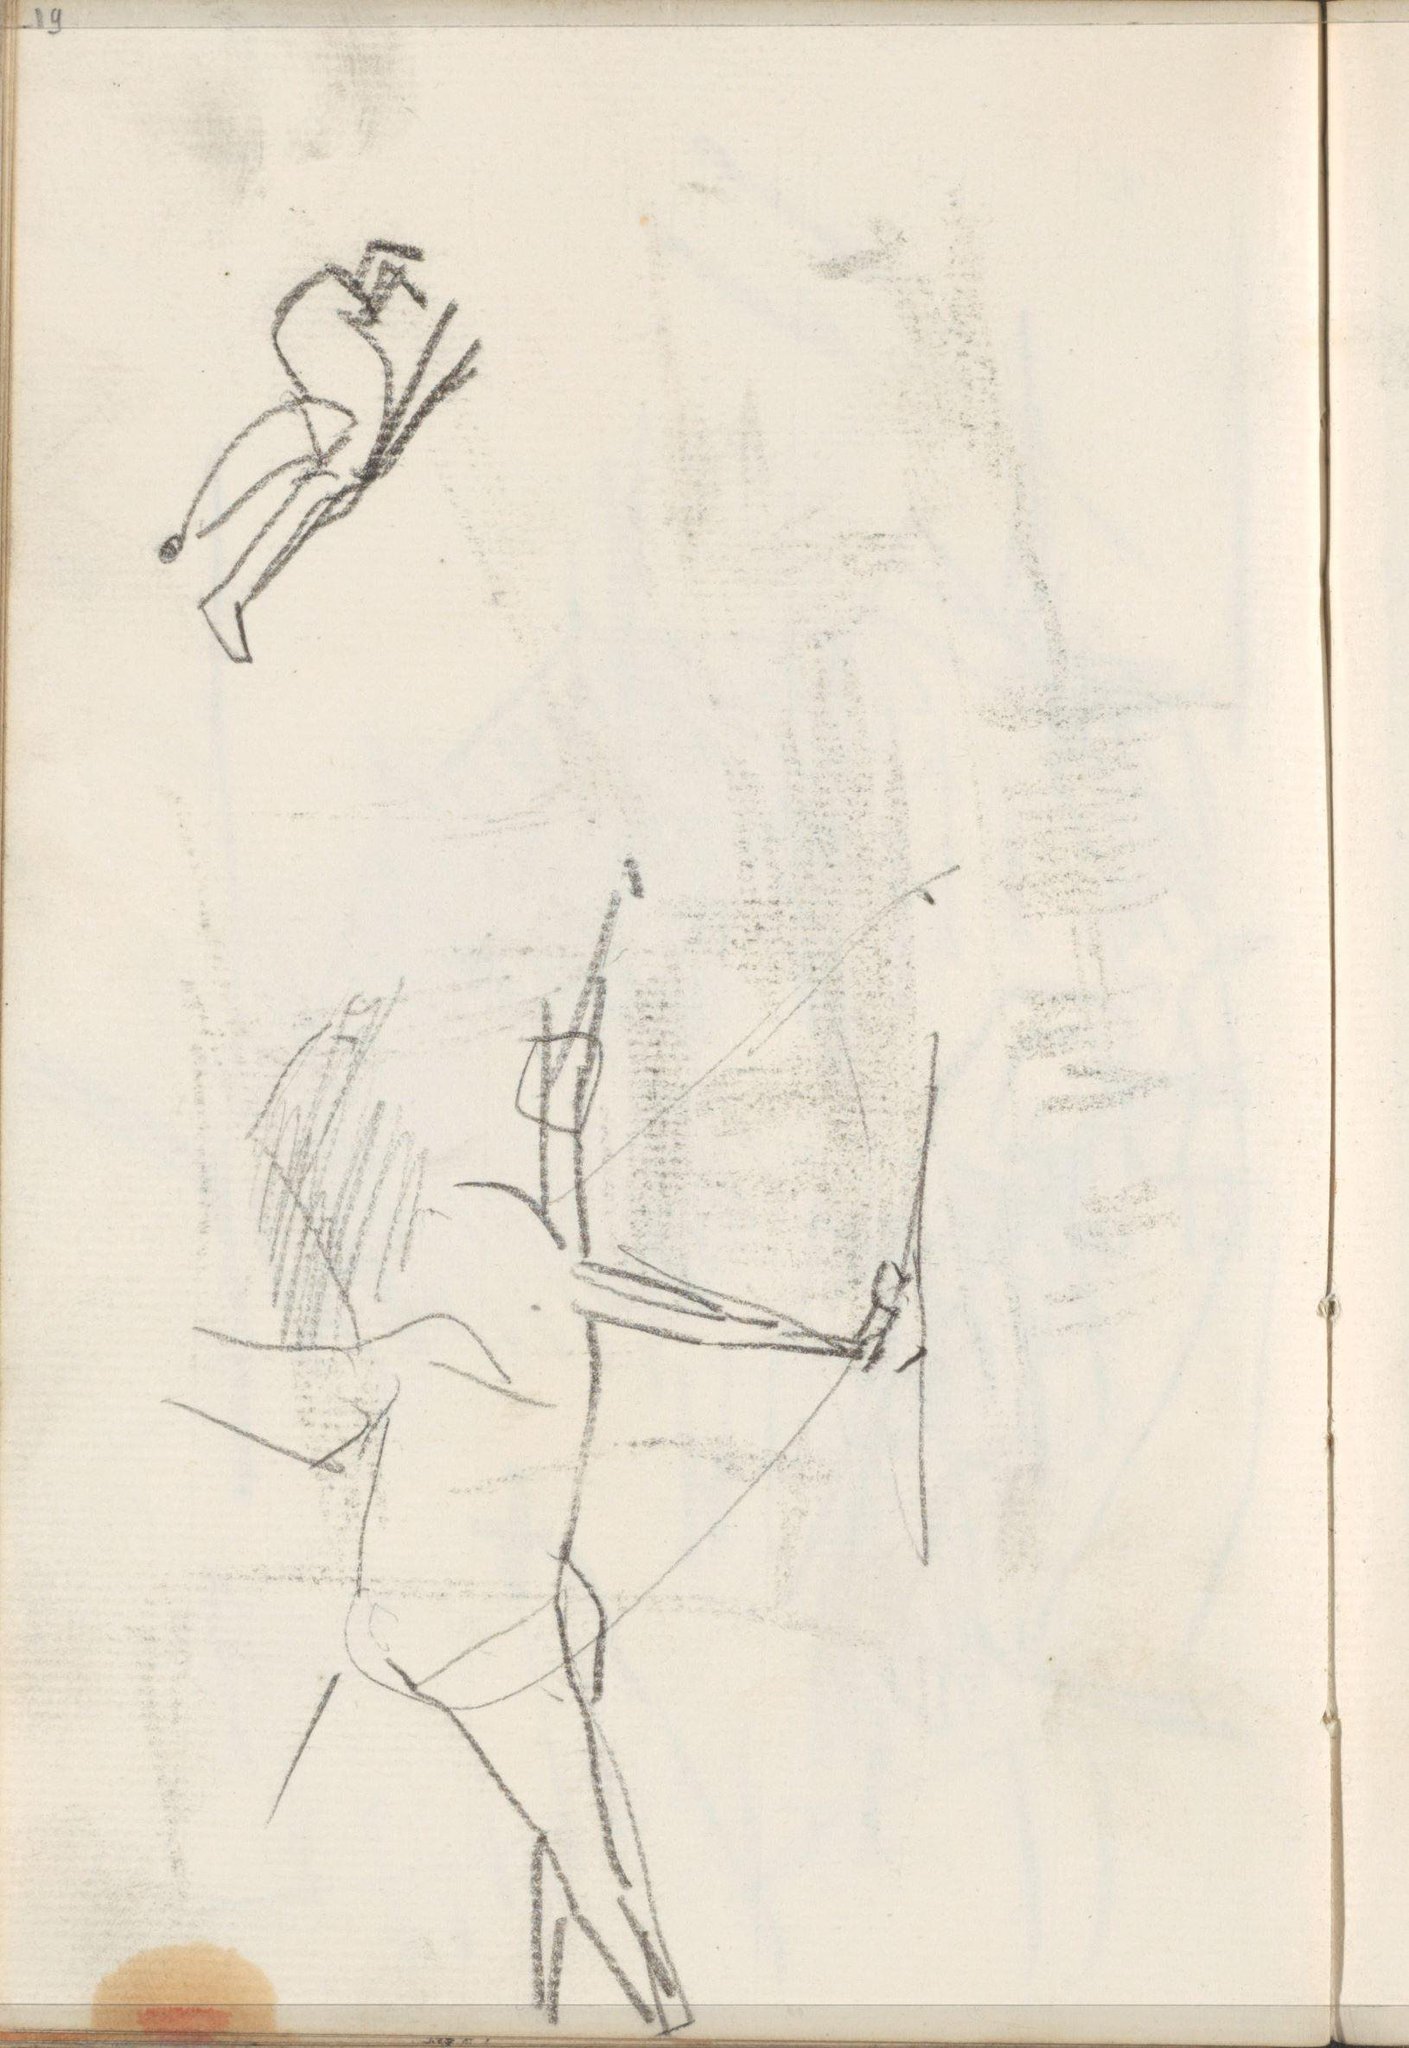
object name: sketchbook leaf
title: Paard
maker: george hendrik breitner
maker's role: draughtsman, painter, print maker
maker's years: 1857-1923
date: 1895-1898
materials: chalk, paper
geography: amsterdam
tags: horse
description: Pagina 19 uit een schetsboek met 20 bladen.